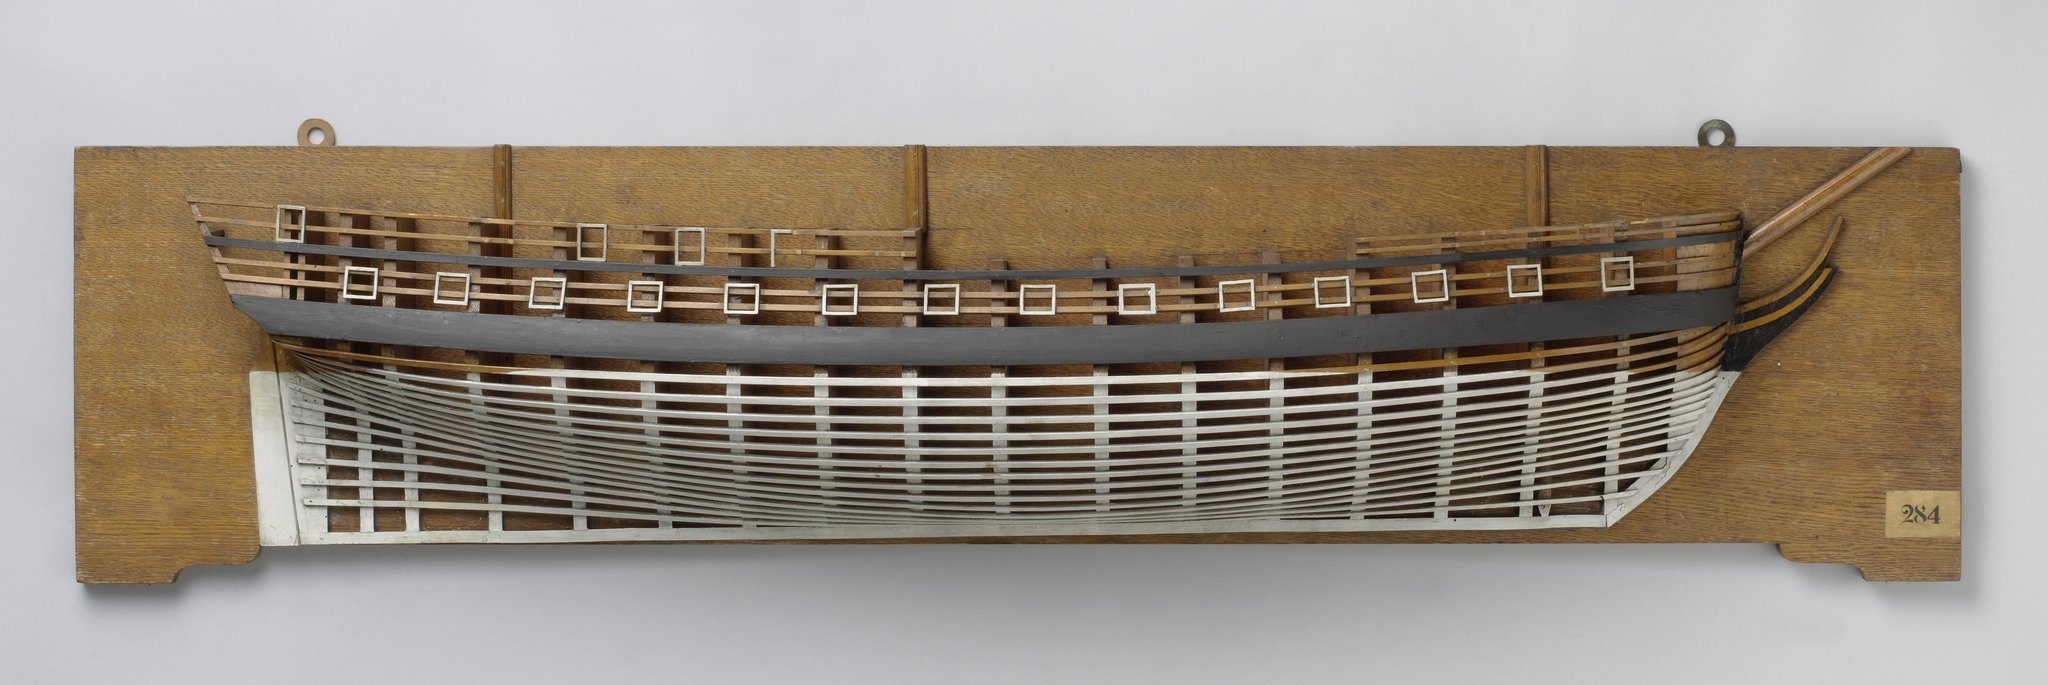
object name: builder's model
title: Half Model of a Frigate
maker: Anonymous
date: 1780-1825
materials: wood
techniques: polychromy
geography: netherlands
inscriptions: label, bottom right: ‘284’ former inventory label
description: Gepolychromeerd mallenmodel (stuurboord) van een driemaster. Vier en twintig geschutpoorten verdeeld over drie dekken. Gewrongen spiegel, hol wulf, geen details van hek of zijgalerij; recht roer met vierkante roerkoning. Zeeg aan beide uiteinden oplopend, één berghout en één reehout. Gepiekt rondspant.